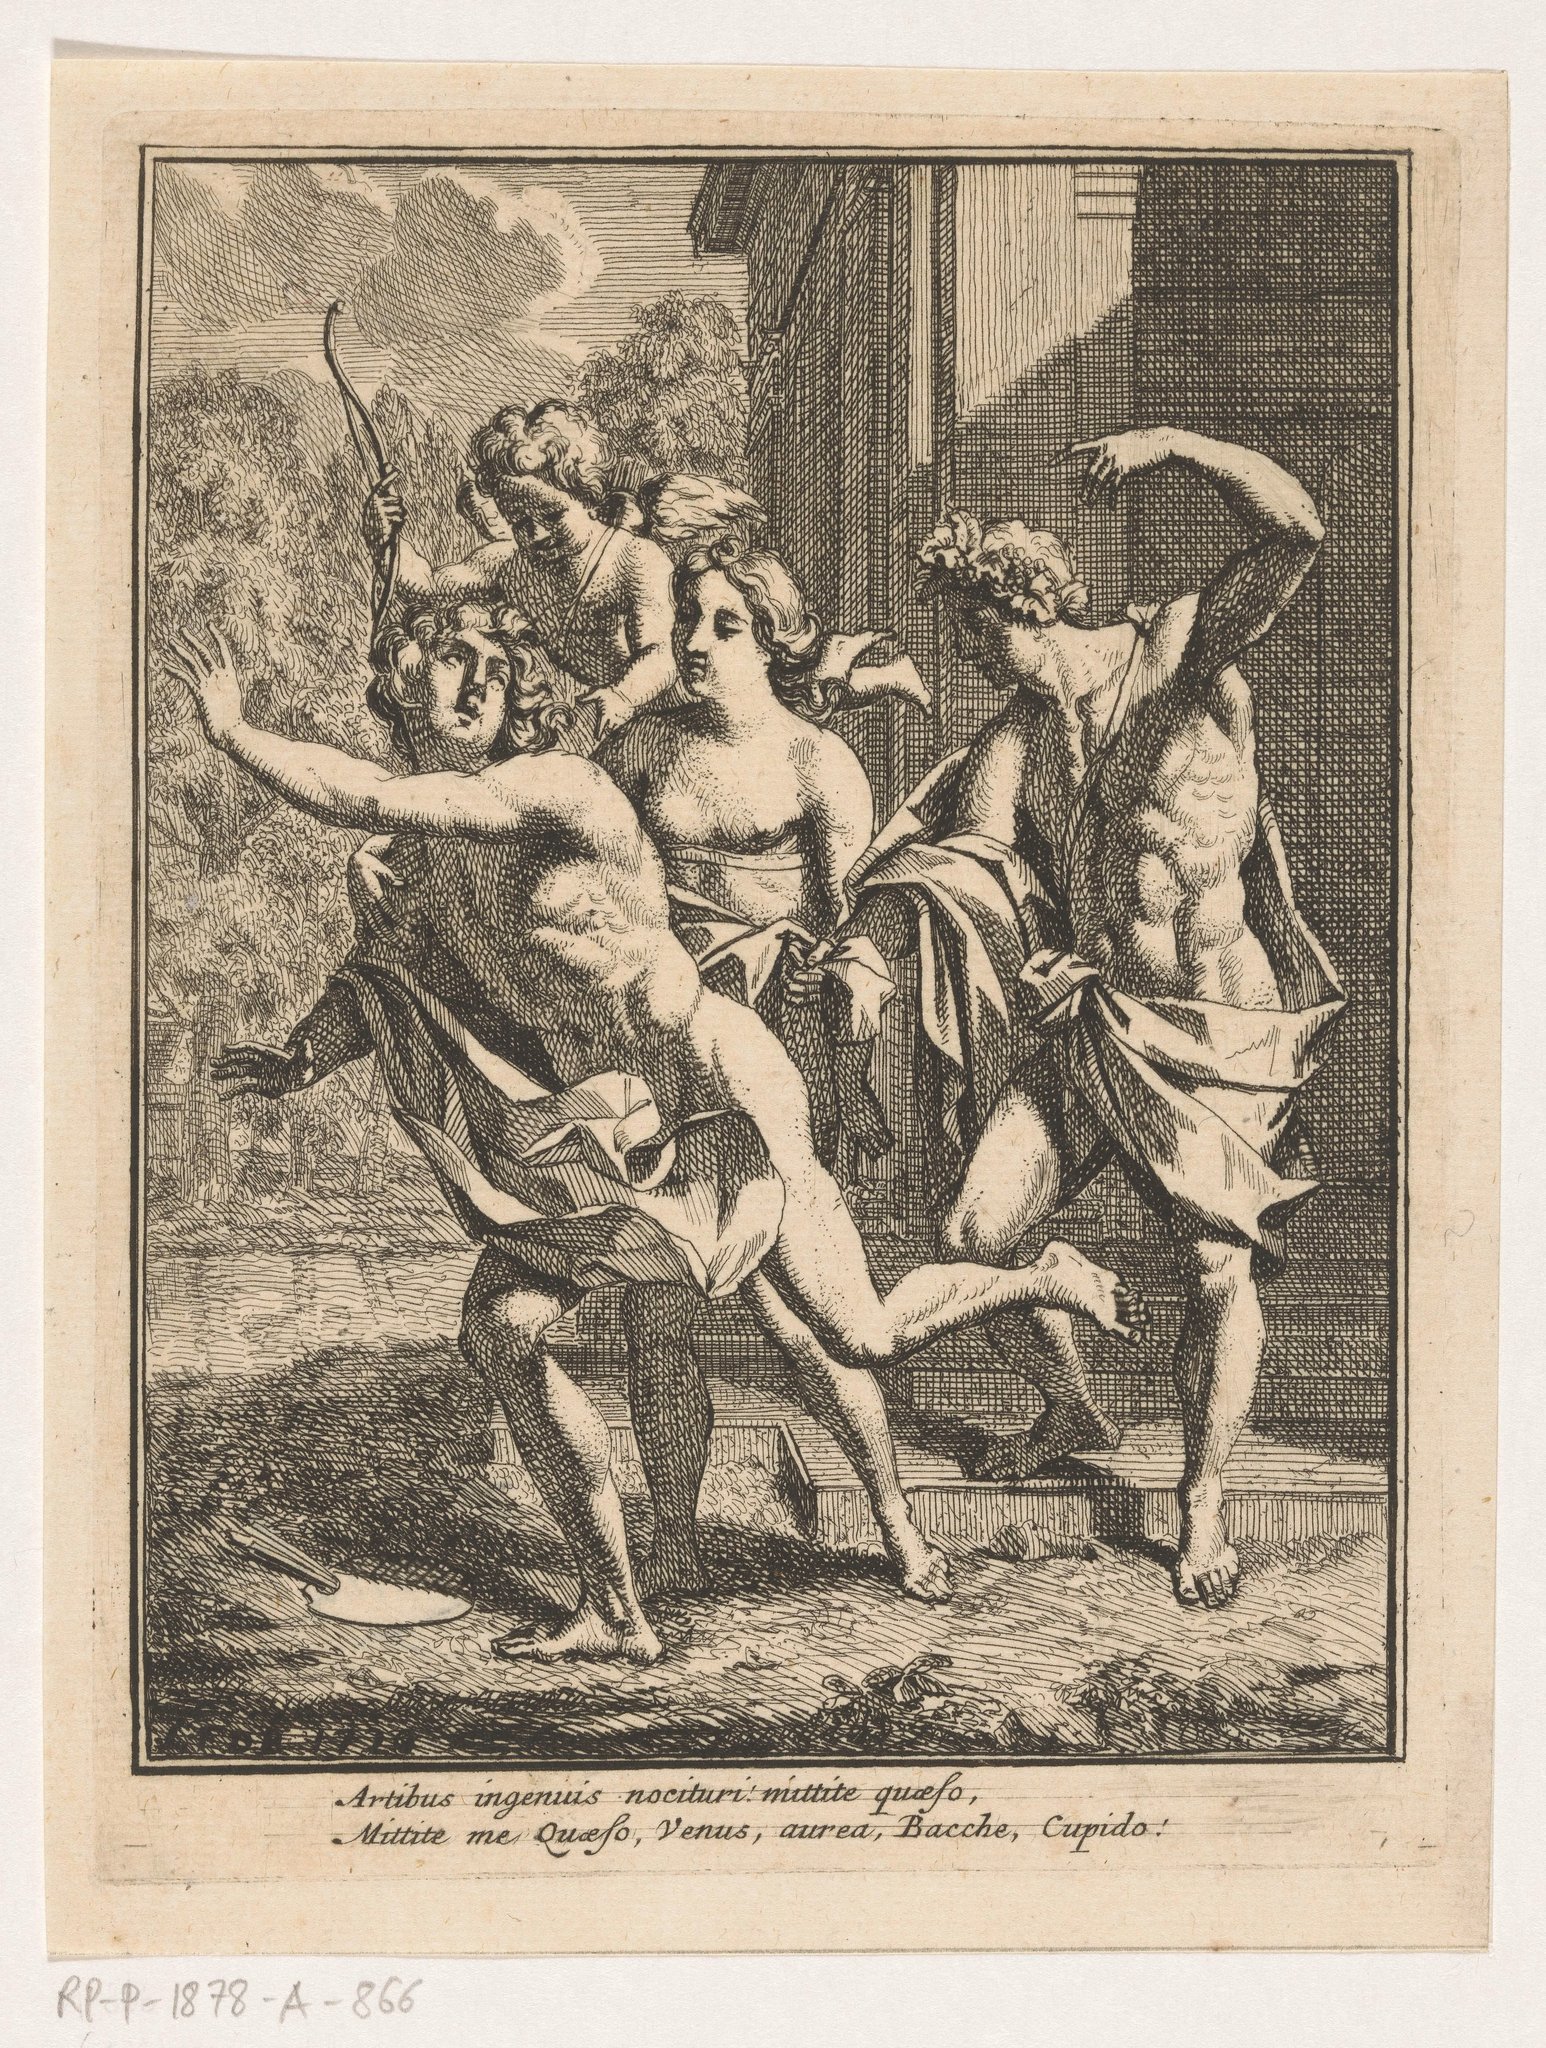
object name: print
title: Een jonge man vlucht voor Bacchus, Venus en Amor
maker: louis fabritius dubourg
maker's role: draughtsman, print maker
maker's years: 1693-1775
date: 1720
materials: paper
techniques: etching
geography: amsterdam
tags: (story of) bacchus (dionysus), liber, venus and cupid (cupid not being mere attribute)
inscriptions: collector's mark: Lugt 237a, collector's mark: Lugt 2228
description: Een jonge man, volgens het Latijnse onderschrift geniaal, ontvlucht Bacchus, Venus en Amor.